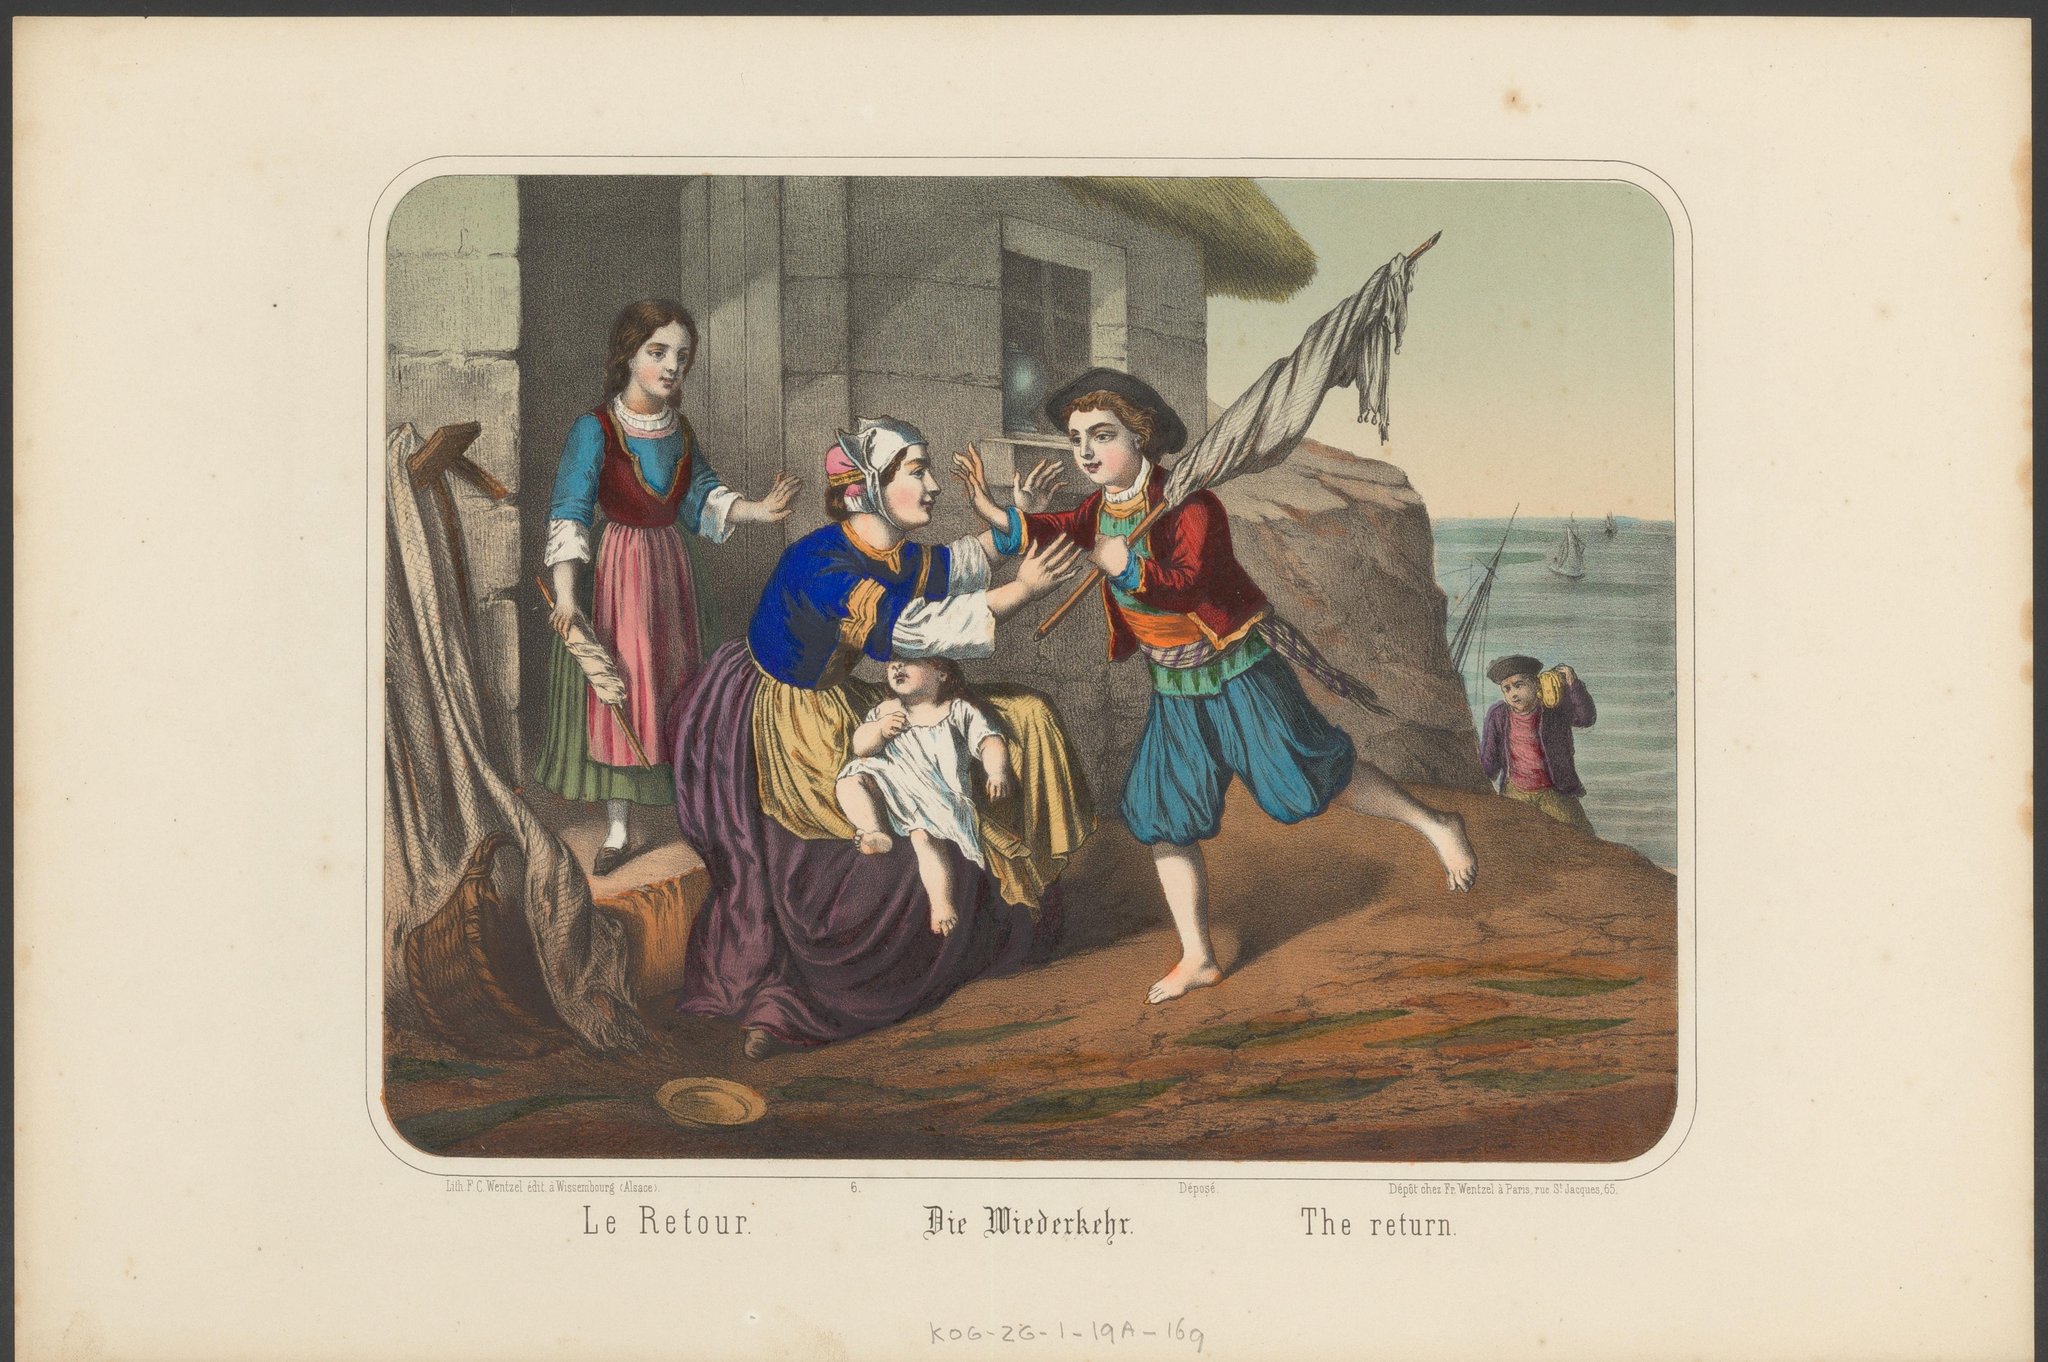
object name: print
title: Kind komt terug van zee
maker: frédéric charles wentzel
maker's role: print maker, publisher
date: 1850-1899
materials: paper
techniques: hand coloring, lithograph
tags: arrival and return ~ travelling, mother and baby or young child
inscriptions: collector's mark: Lugt 1641, stamp: Lugt 2233, : ‘Déposé’, stamp:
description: Onderaan genummerd: 6. Onderwerpsrubrieken binnen de Atlas Zeden en Gewoonten: Zeden en Gewoonten in Engeren Zin, Des menschen beging, midden en einde, Kinderleven – Kinderspel en Kinderprenten.